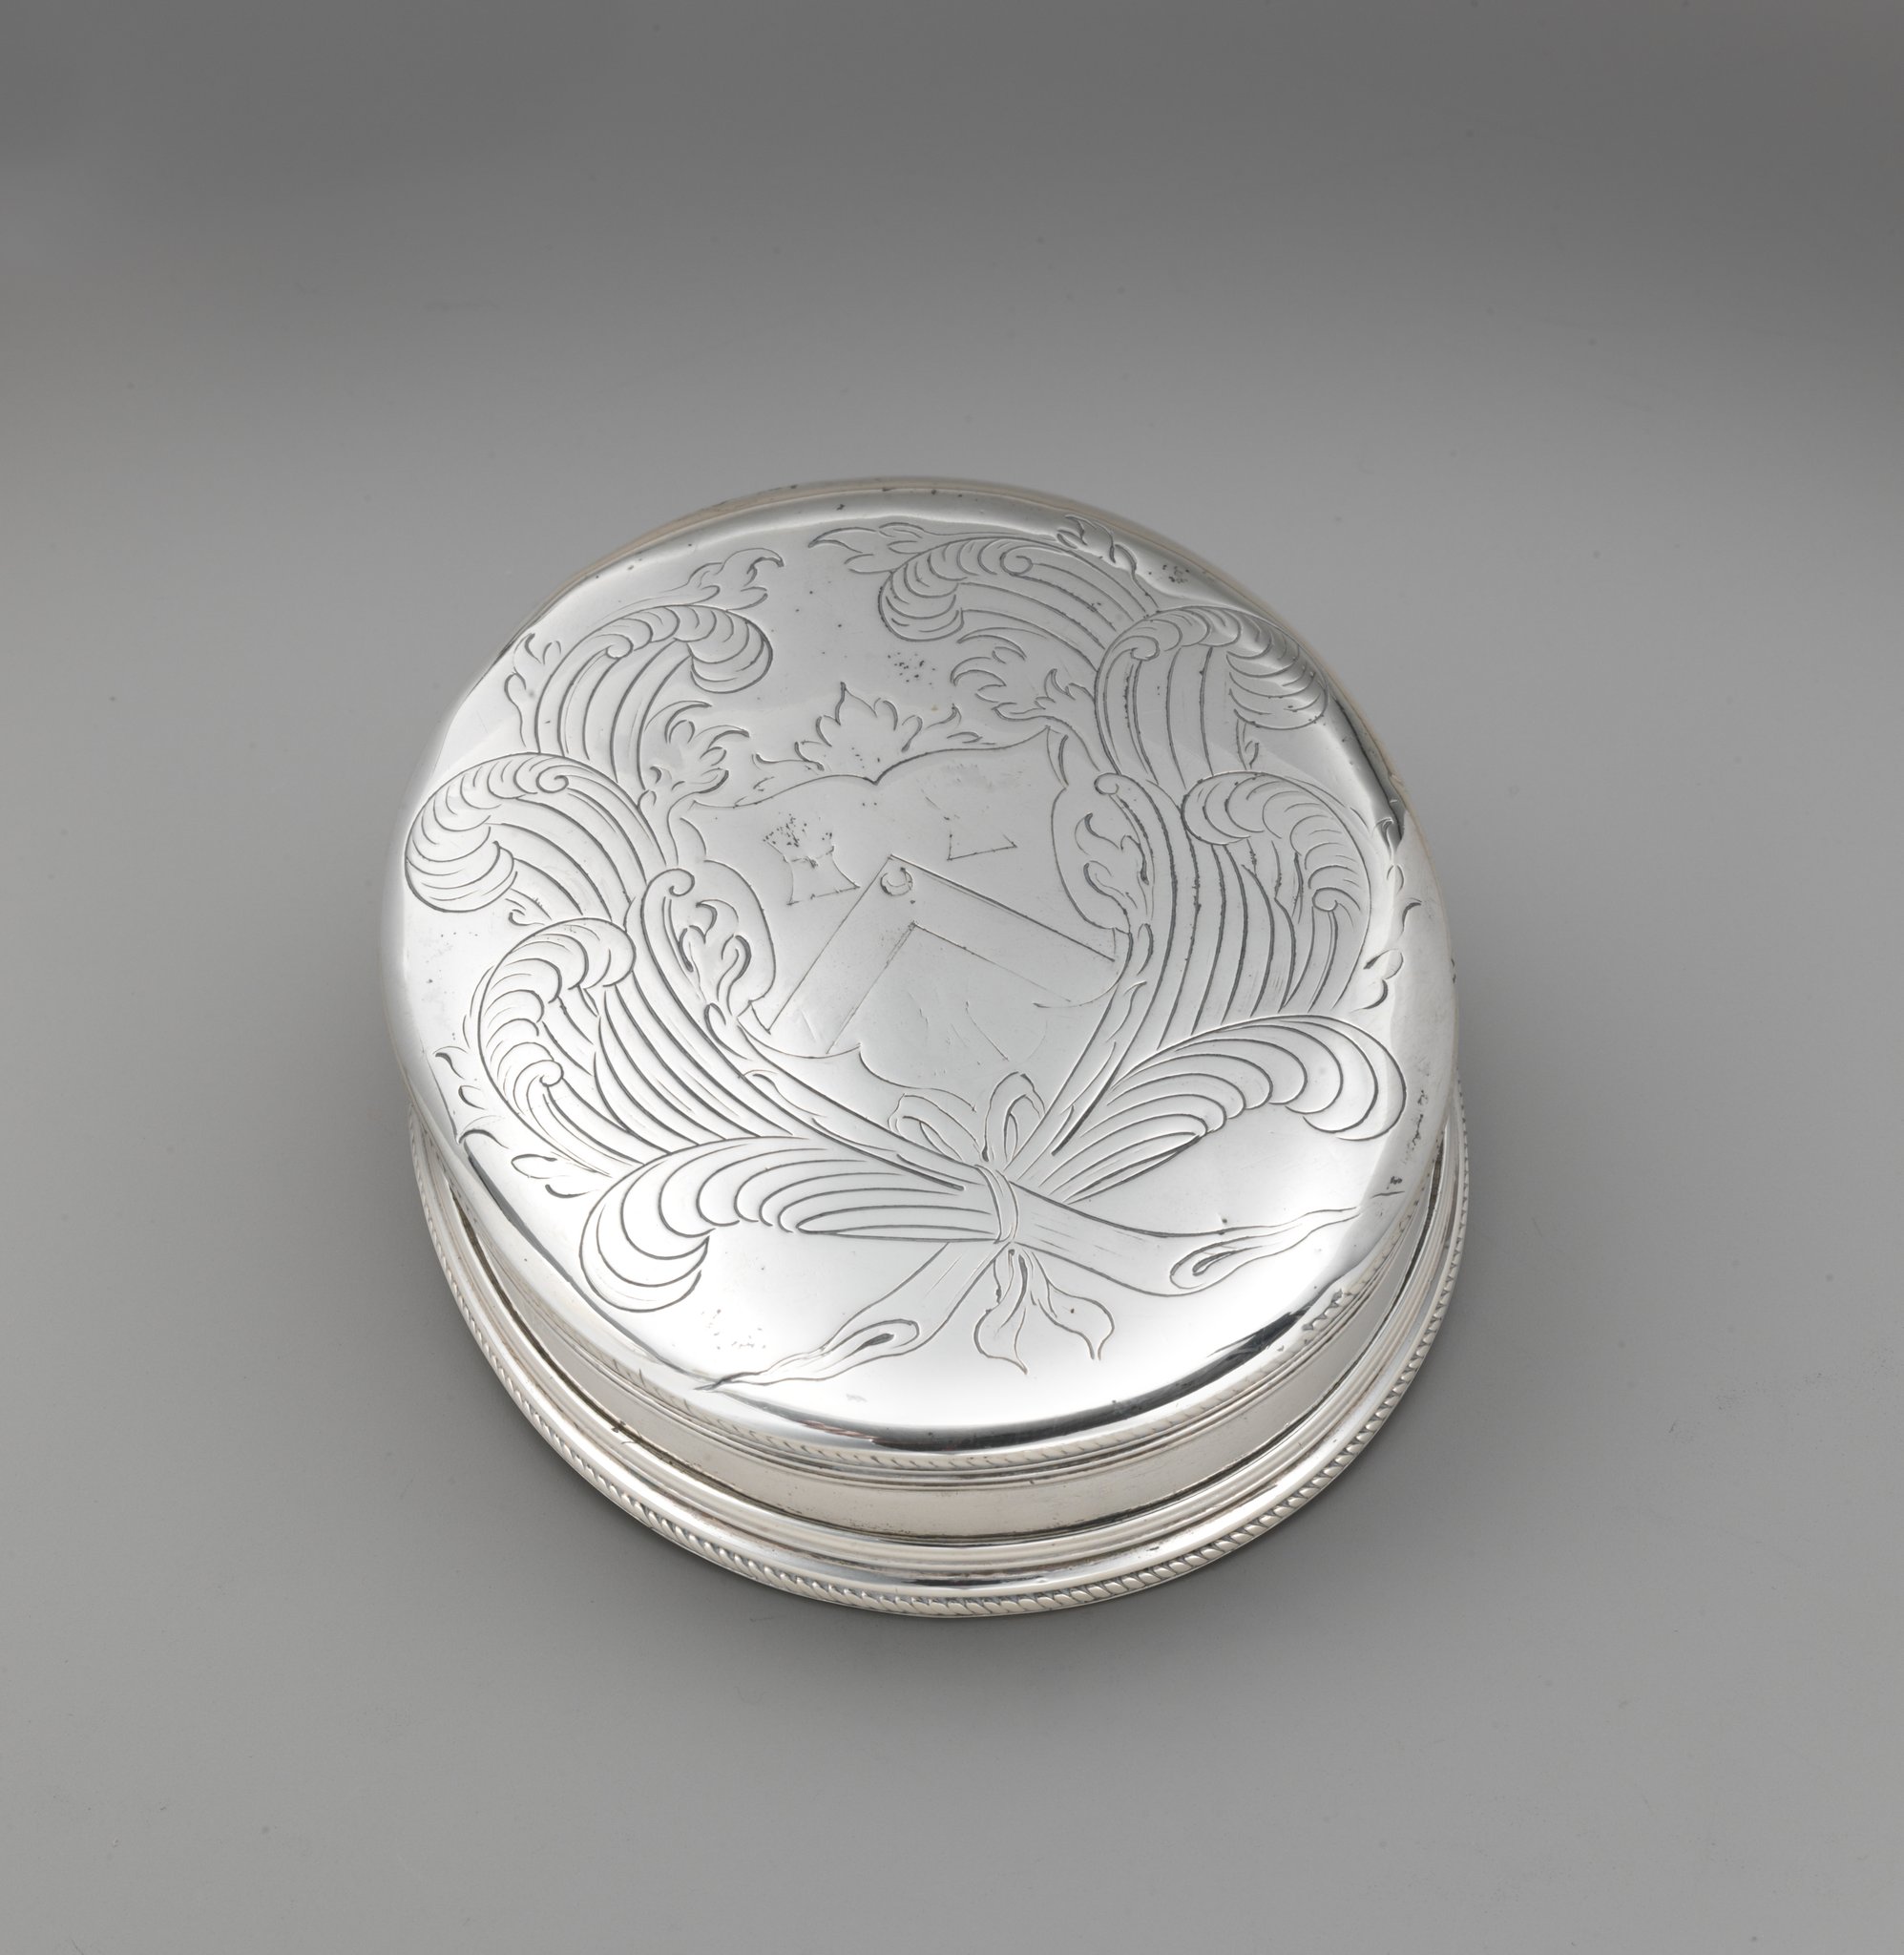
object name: tobacco box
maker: caleb westbrooke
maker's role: maker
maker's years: 1669-1691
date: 1691-1692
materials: silver